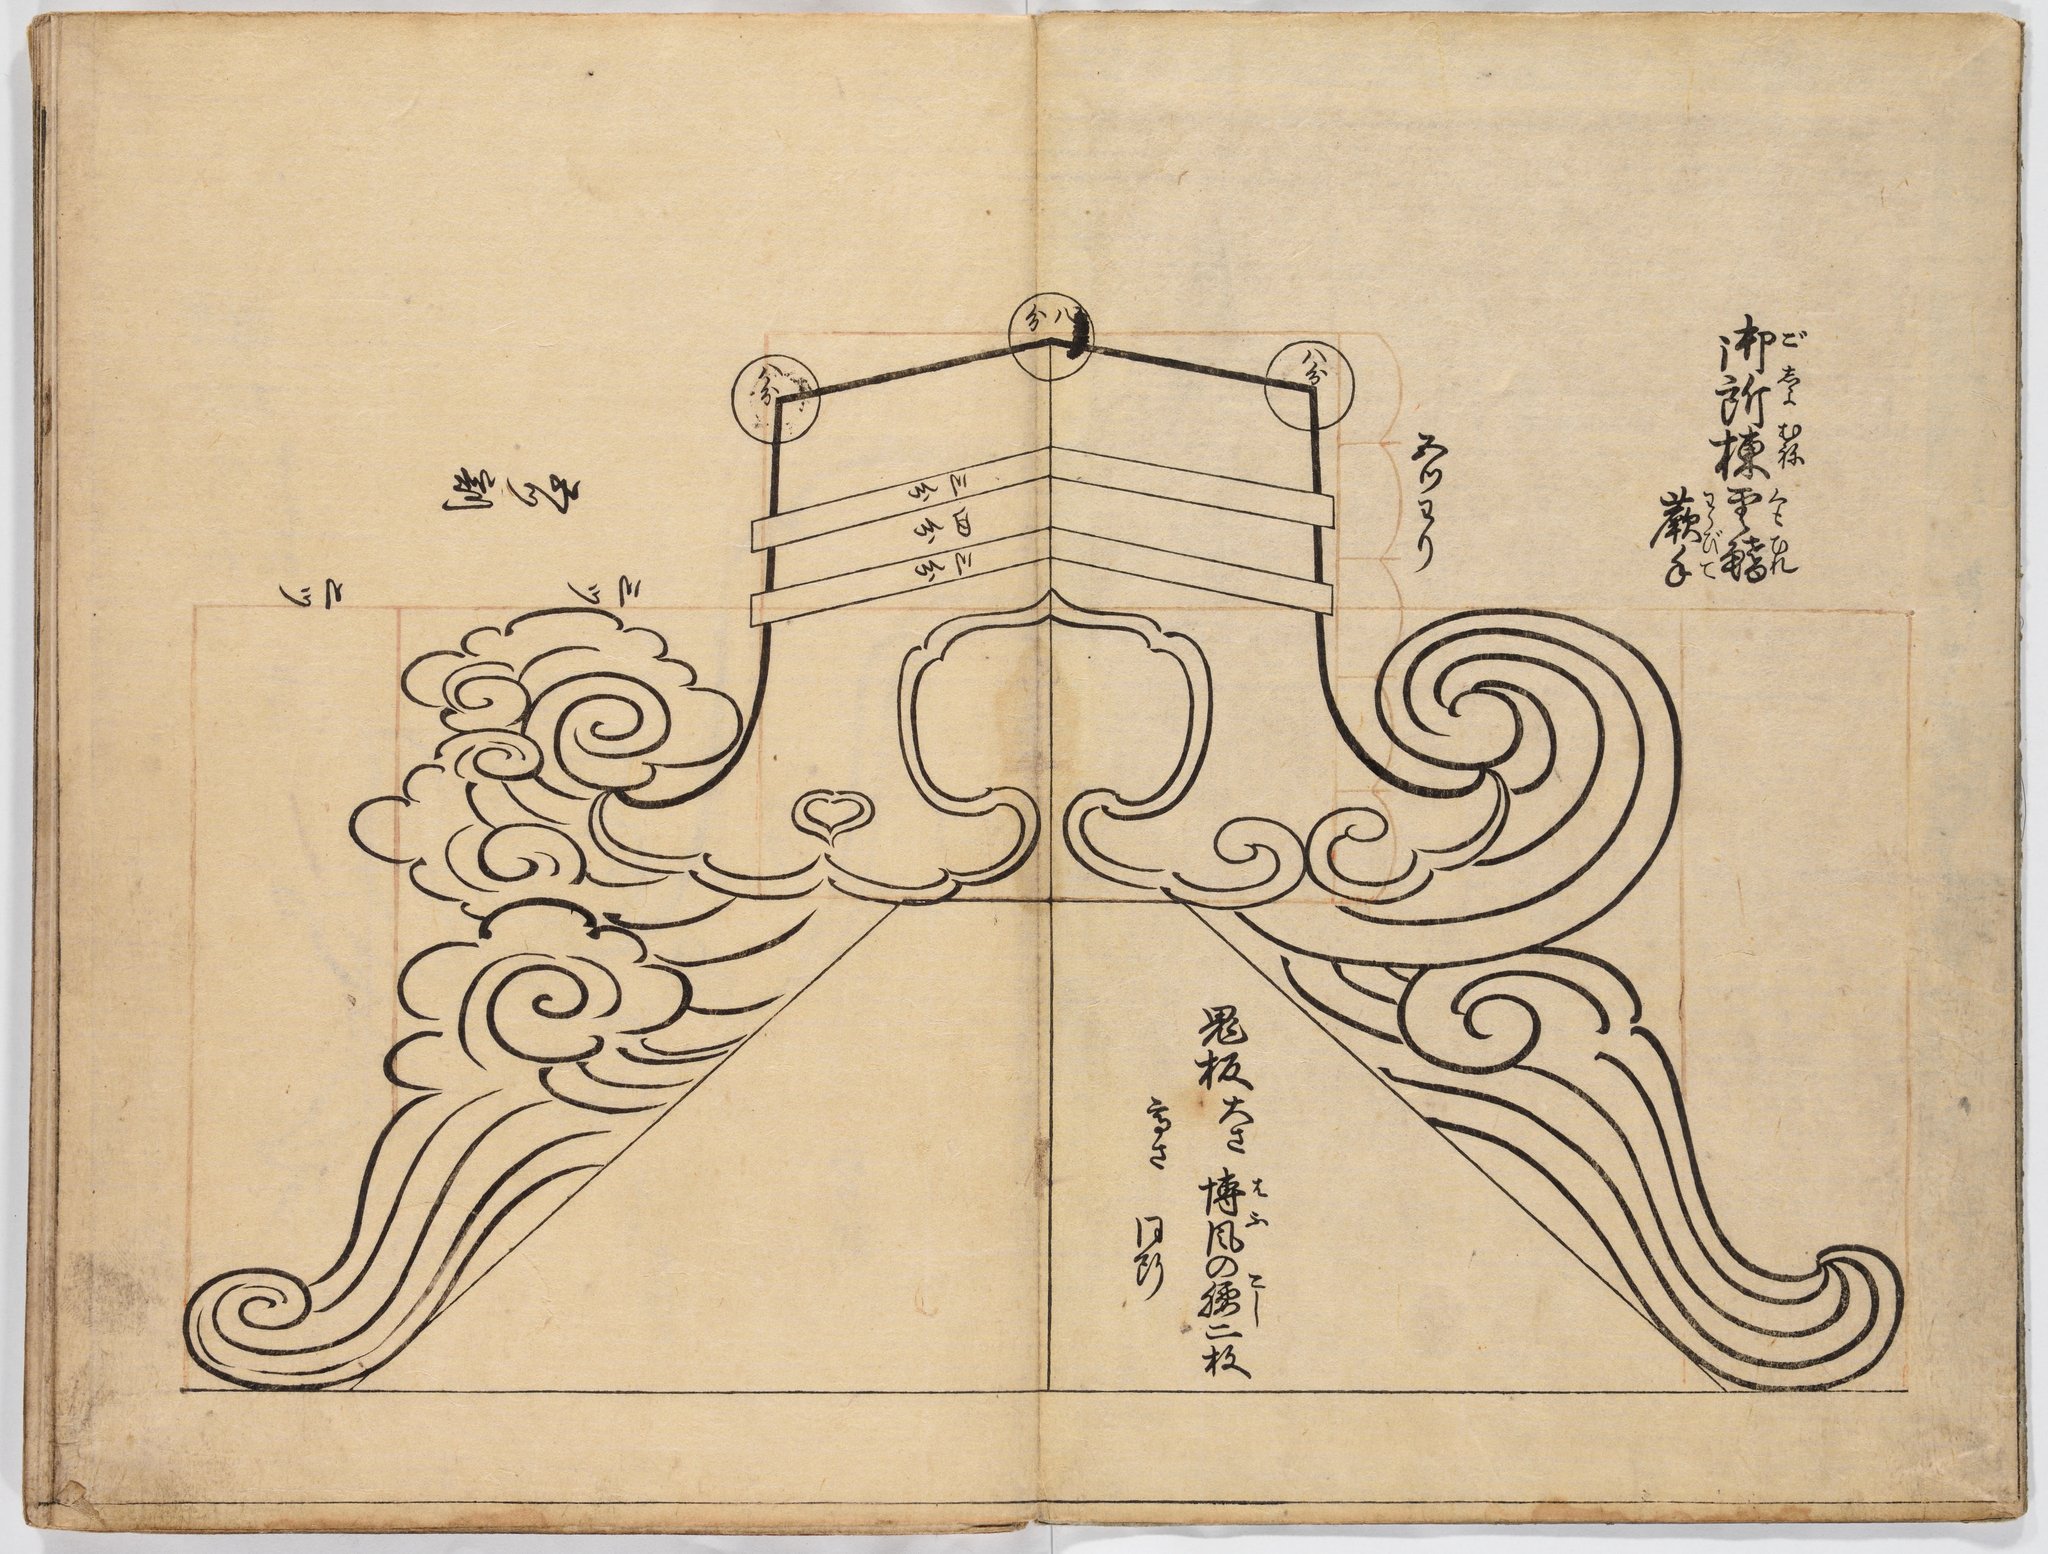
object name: illustrated book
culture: japanese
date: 1893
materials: ink, paper